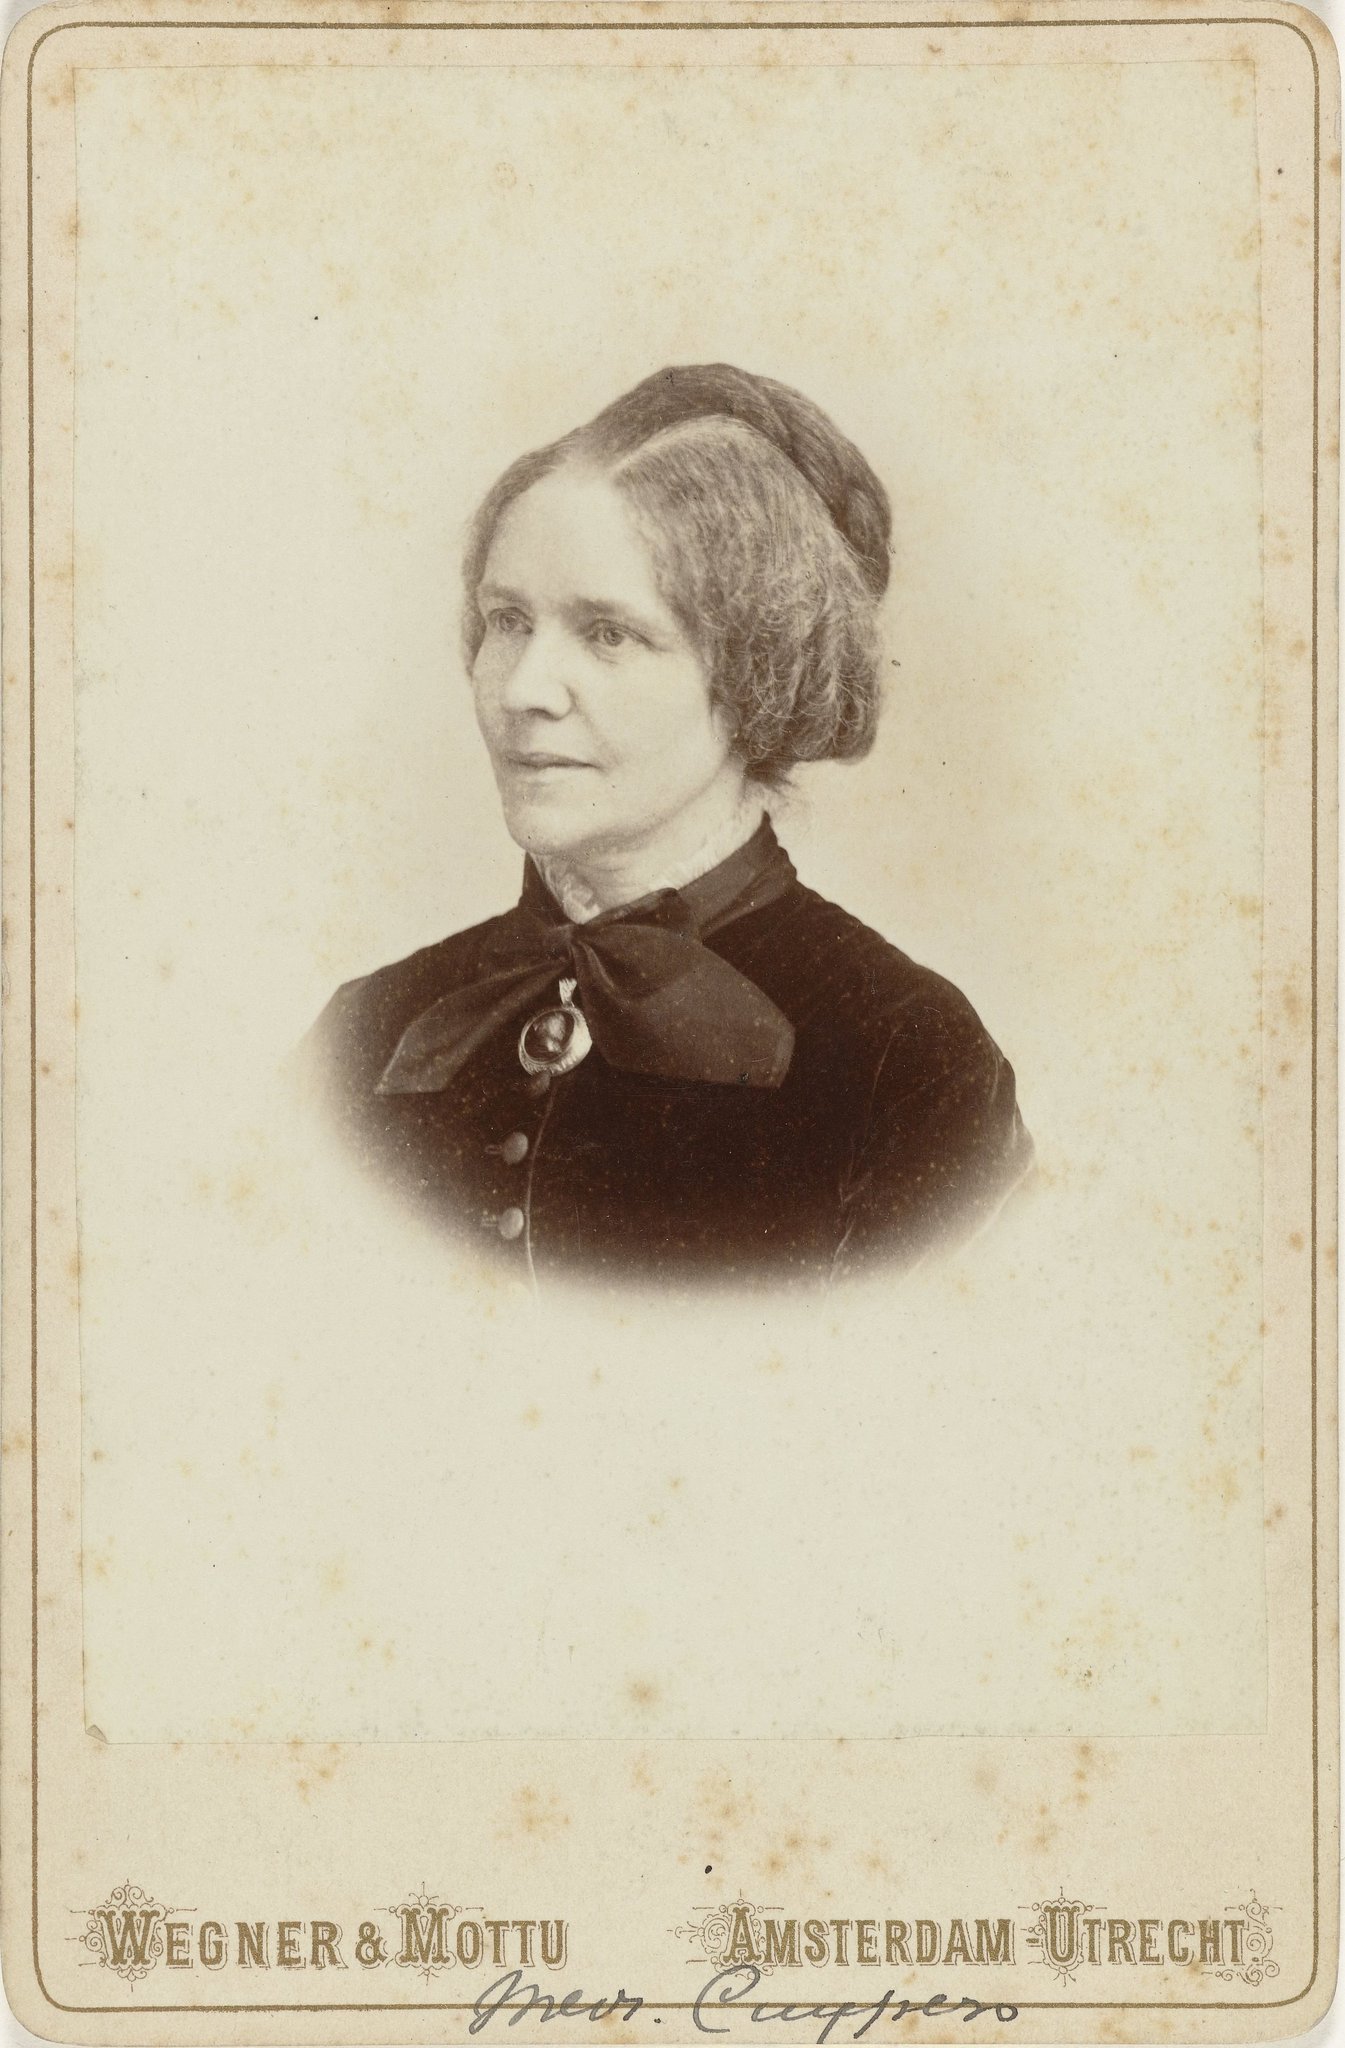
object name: photograph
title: Portret van mevrouw Cuypers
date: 1850-1899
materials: cardboard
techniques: photography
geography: utrecht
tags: draughtsman, pierre joseph hubert cuypers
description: Foto op karton, van een vrouw (mevr. Cuypers).